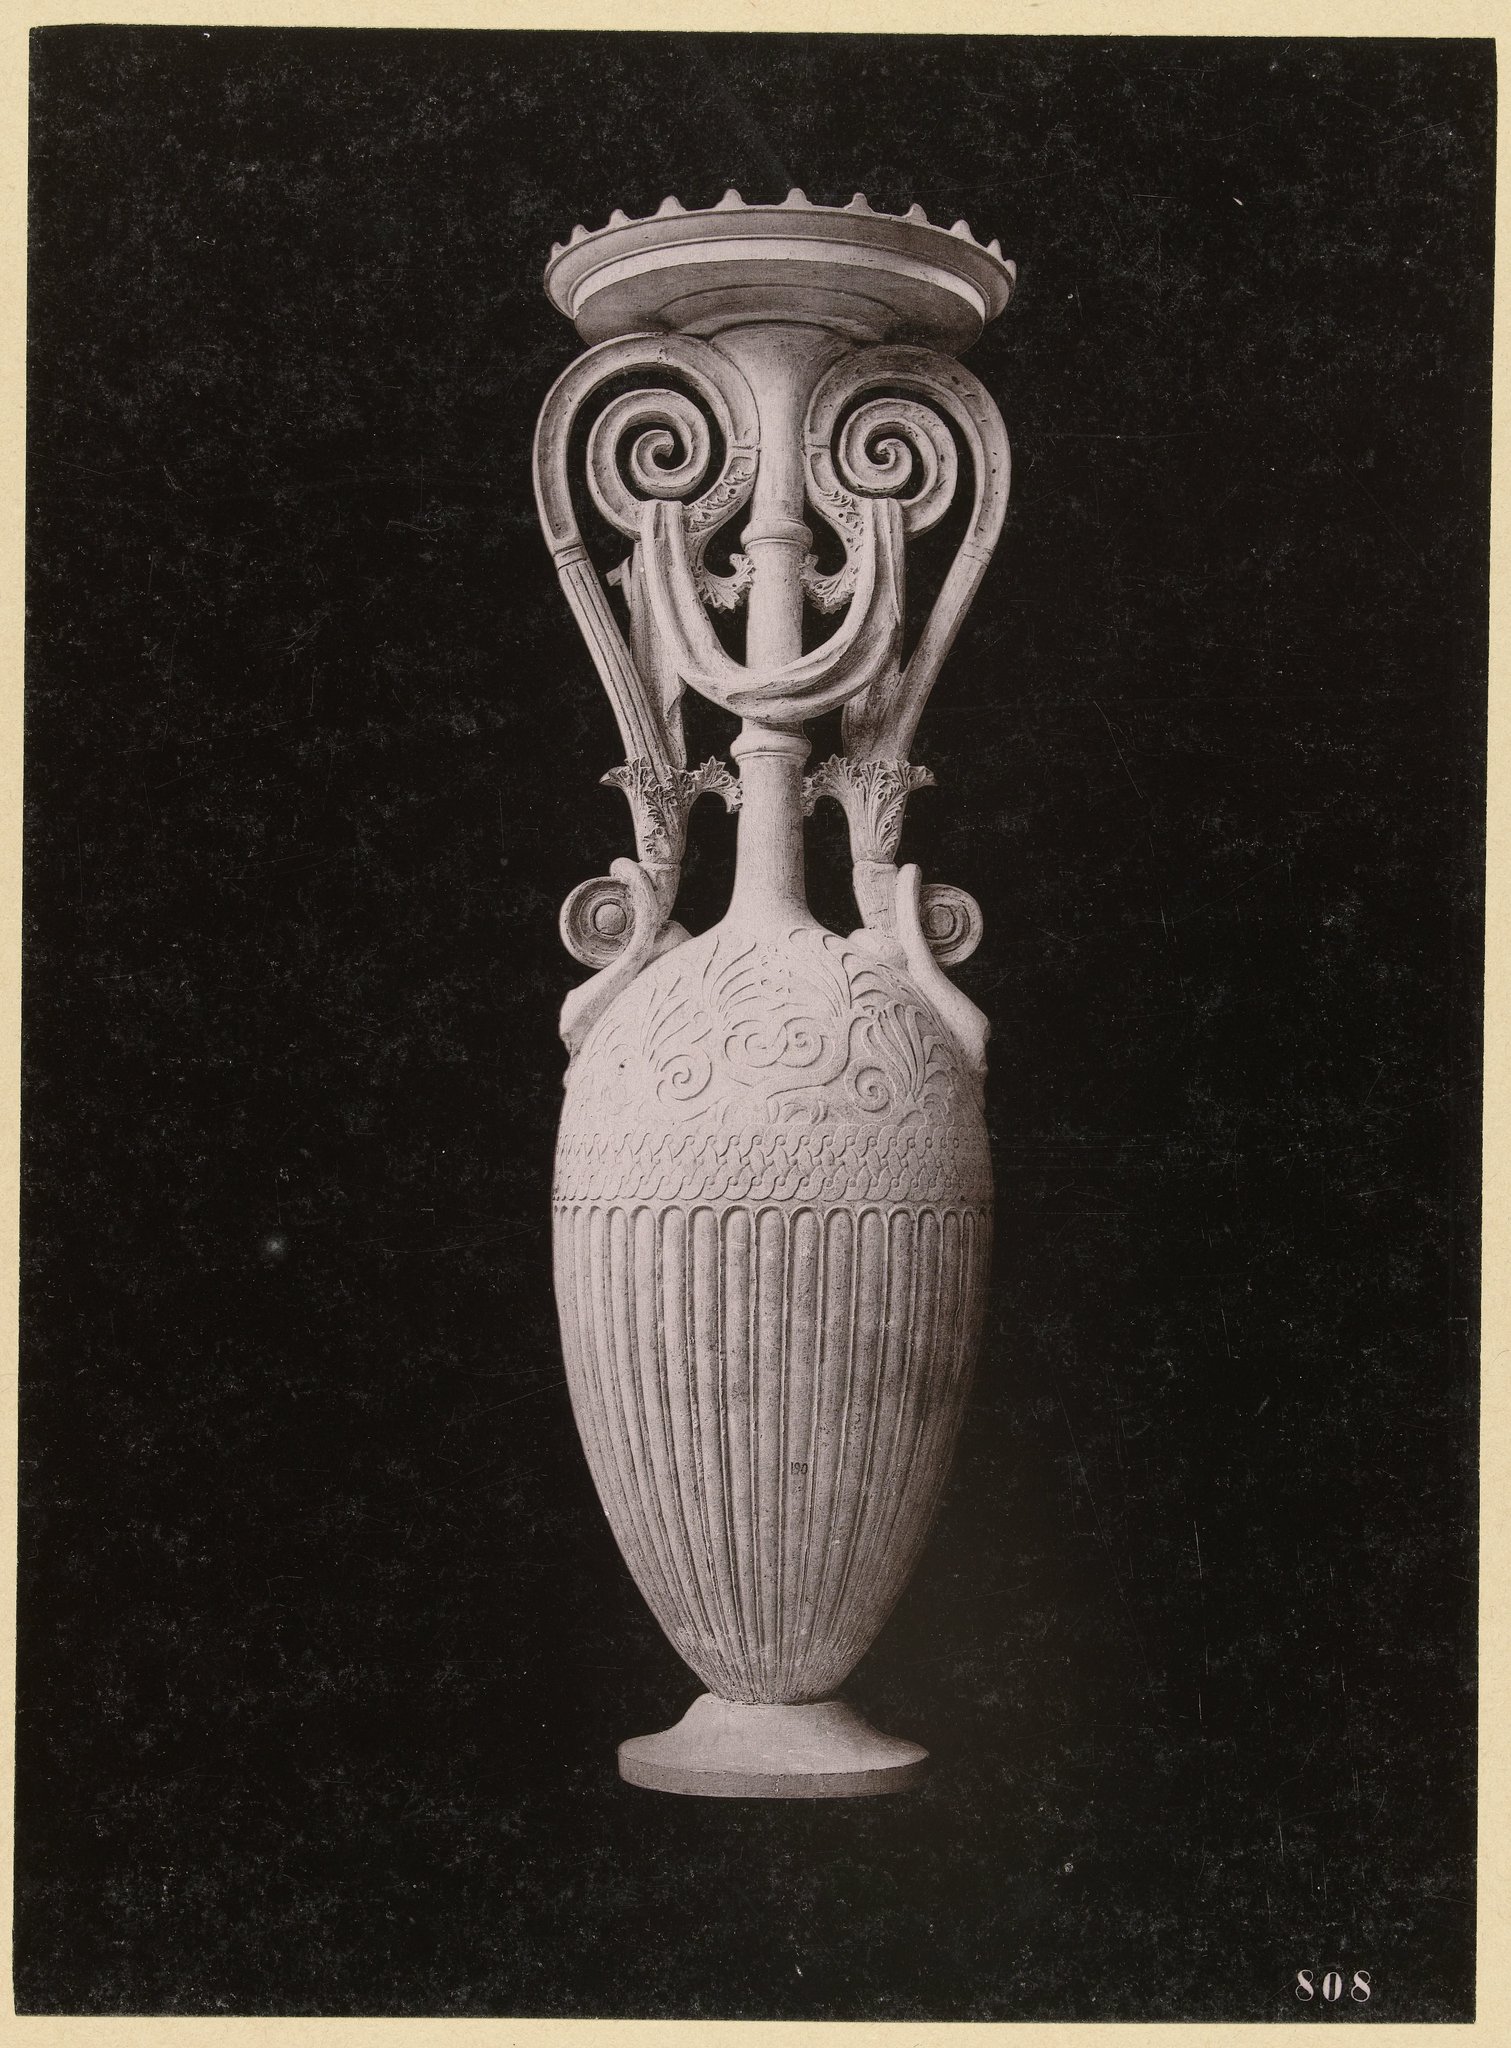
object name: photomechanical print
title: Decoratieve vaas van zandsteen uit het oude Griekenland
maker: Anonymous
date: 1890-1893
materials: cardboard, paper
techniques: photograph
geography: athens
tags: piece of sculpture, reproduction of a piece of sculpture, container of stone: stone vase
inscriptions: check stamp: ‘Bristol/ L.M.’, stamp: ‘Gemeentelijke bibliotheek/ Rotterdam’, number: ‘808’, title: ‘G 37. Zandstenen vaas. Nationaal Museum, Athene.’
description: Onderdeel van een groep door fotograaf Richard Polak op reis verzamelde foto’s. Deze fotomechanische afdruk is samen met andere op zijn reizen verzamelde foto's tentoongesteld bij de Rotterdamsche Kunstkring (1895), Arti en Amicitiae te Amsterdam (1897-1898?) en Societeit 't Collegie te Kampen (datum vooralsnog onbekend).